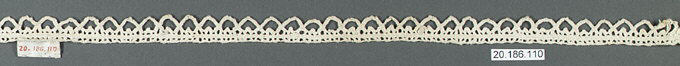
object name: edging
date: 1501-1600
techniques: lace